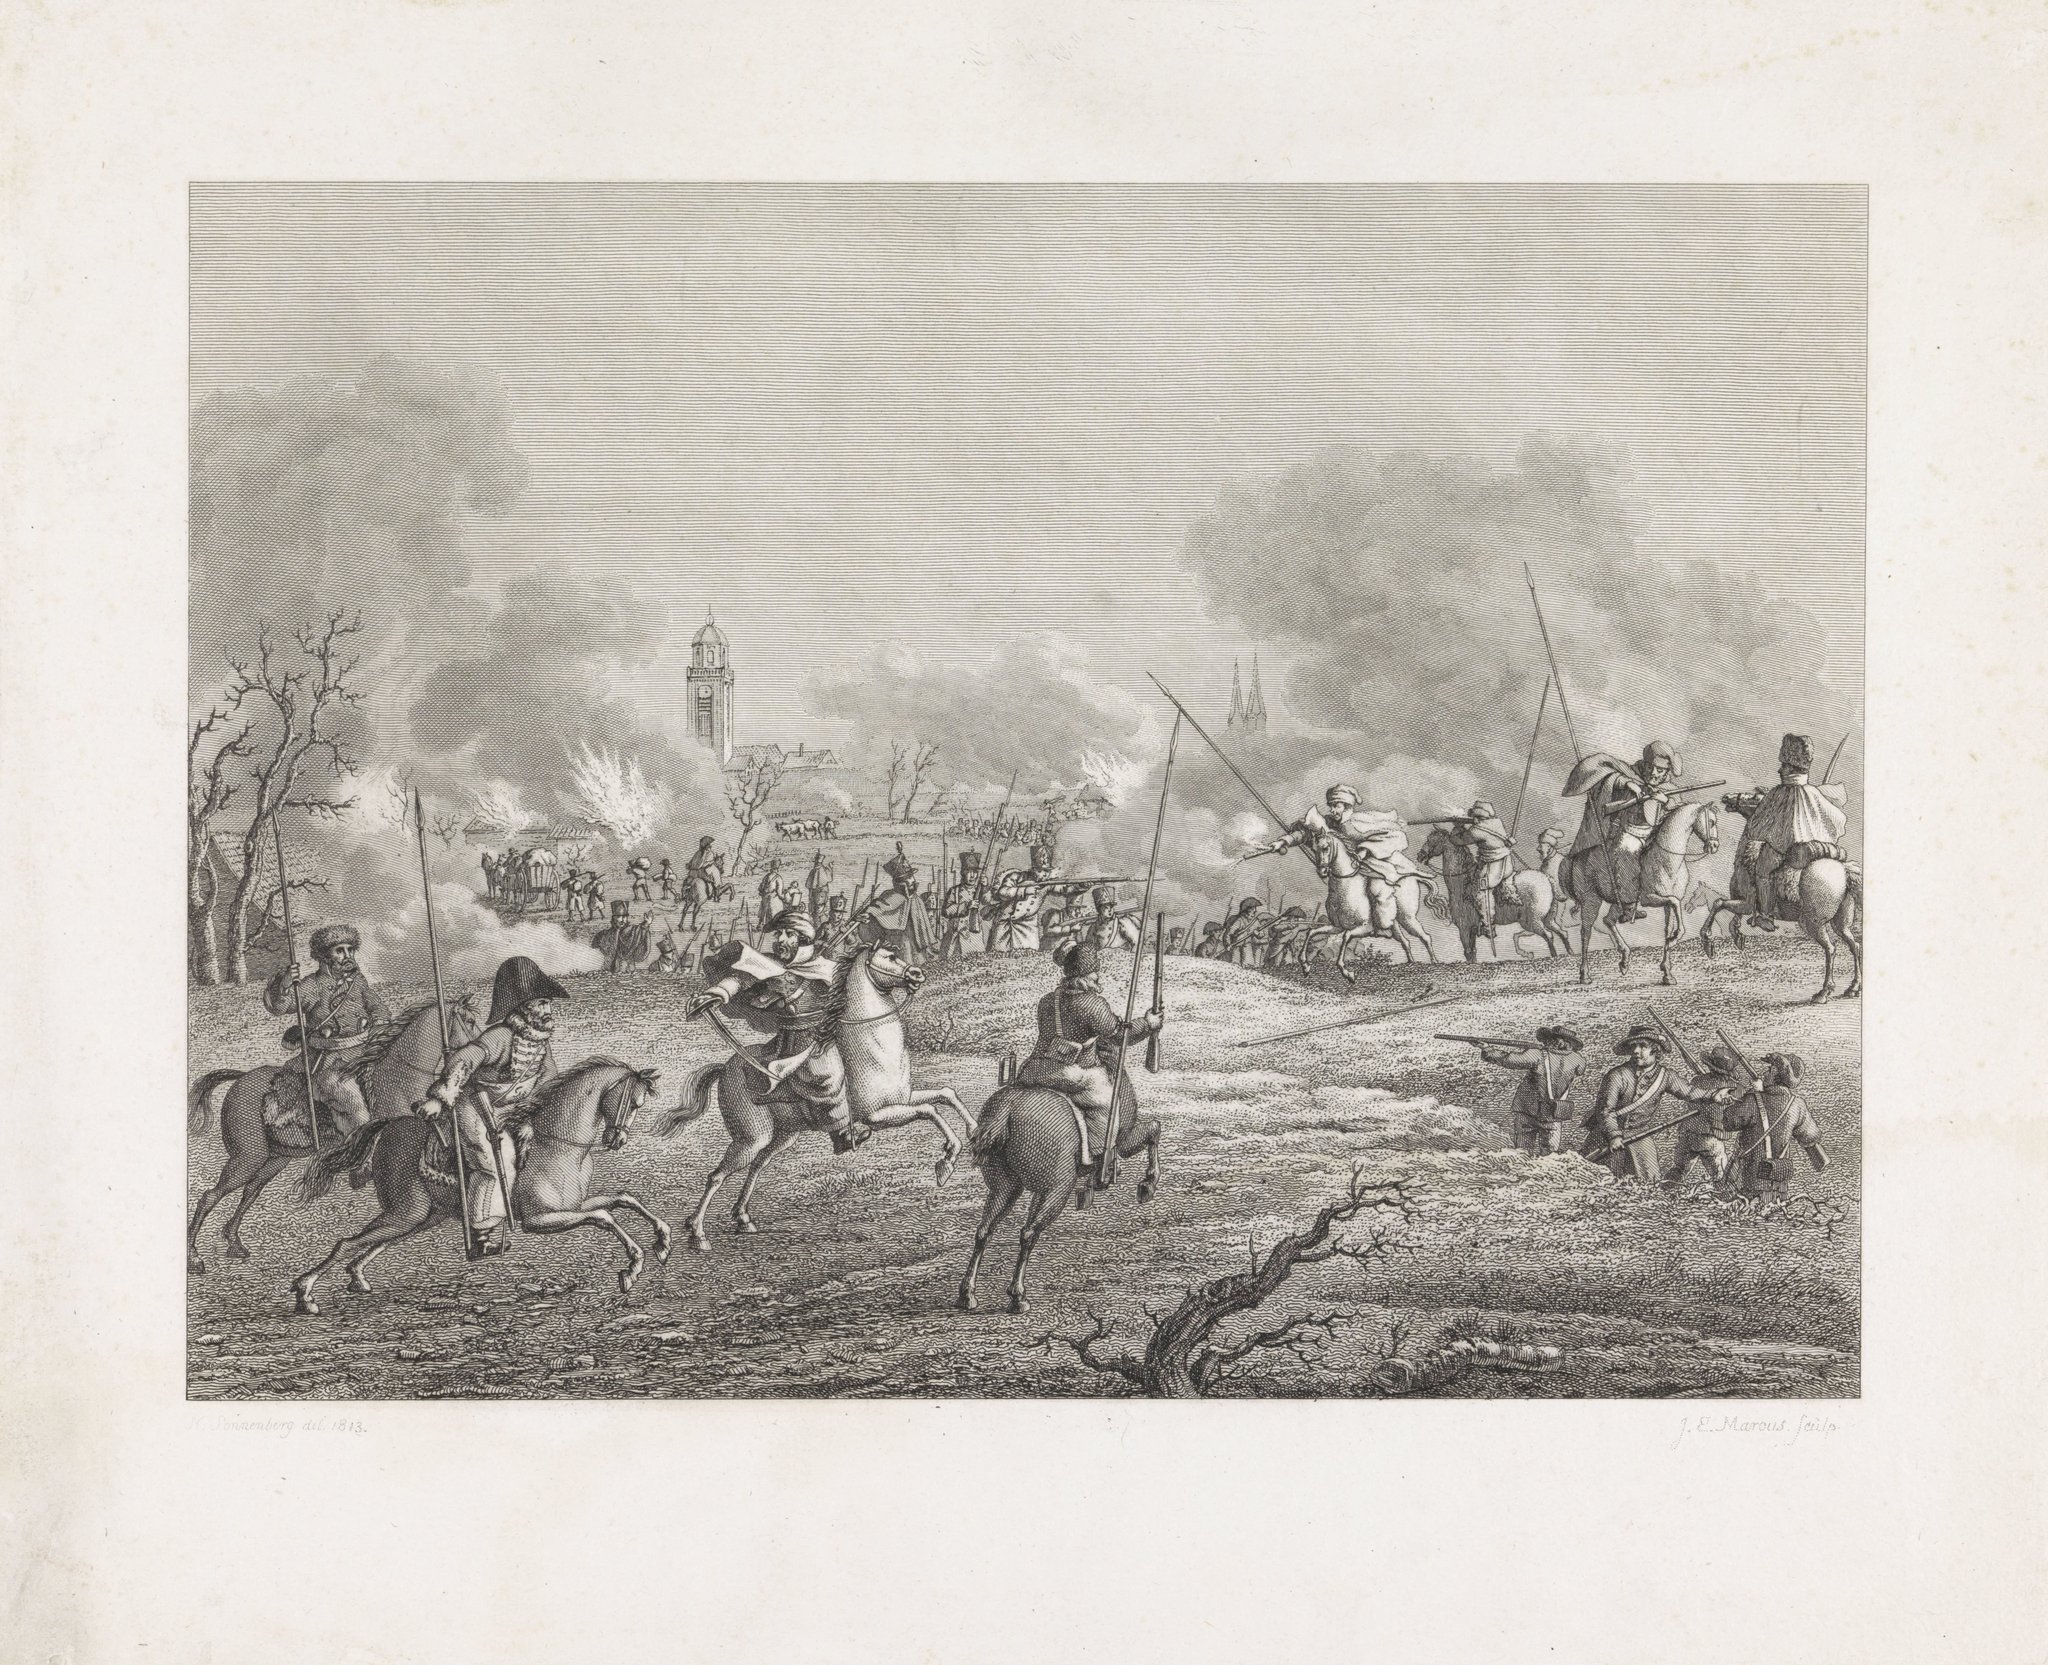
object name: print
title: Gevechten tussen Fransen en kozakken bij Deventer, 1813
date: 1813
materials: paper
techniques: engraving, etching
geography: netherlands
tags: battle (+ land forces), deventer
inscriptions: collector's mark: Lugt 2228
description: Gevechten tussen Franse soldaten en Russische kozakken buiten Deventer, 26 november 1813. Op de voorgrond het gevecht tussen Franse voetsoldaten en kozakken te paard, op de achtergrond brandende huizen en bewoners die op de vlucht slaan.